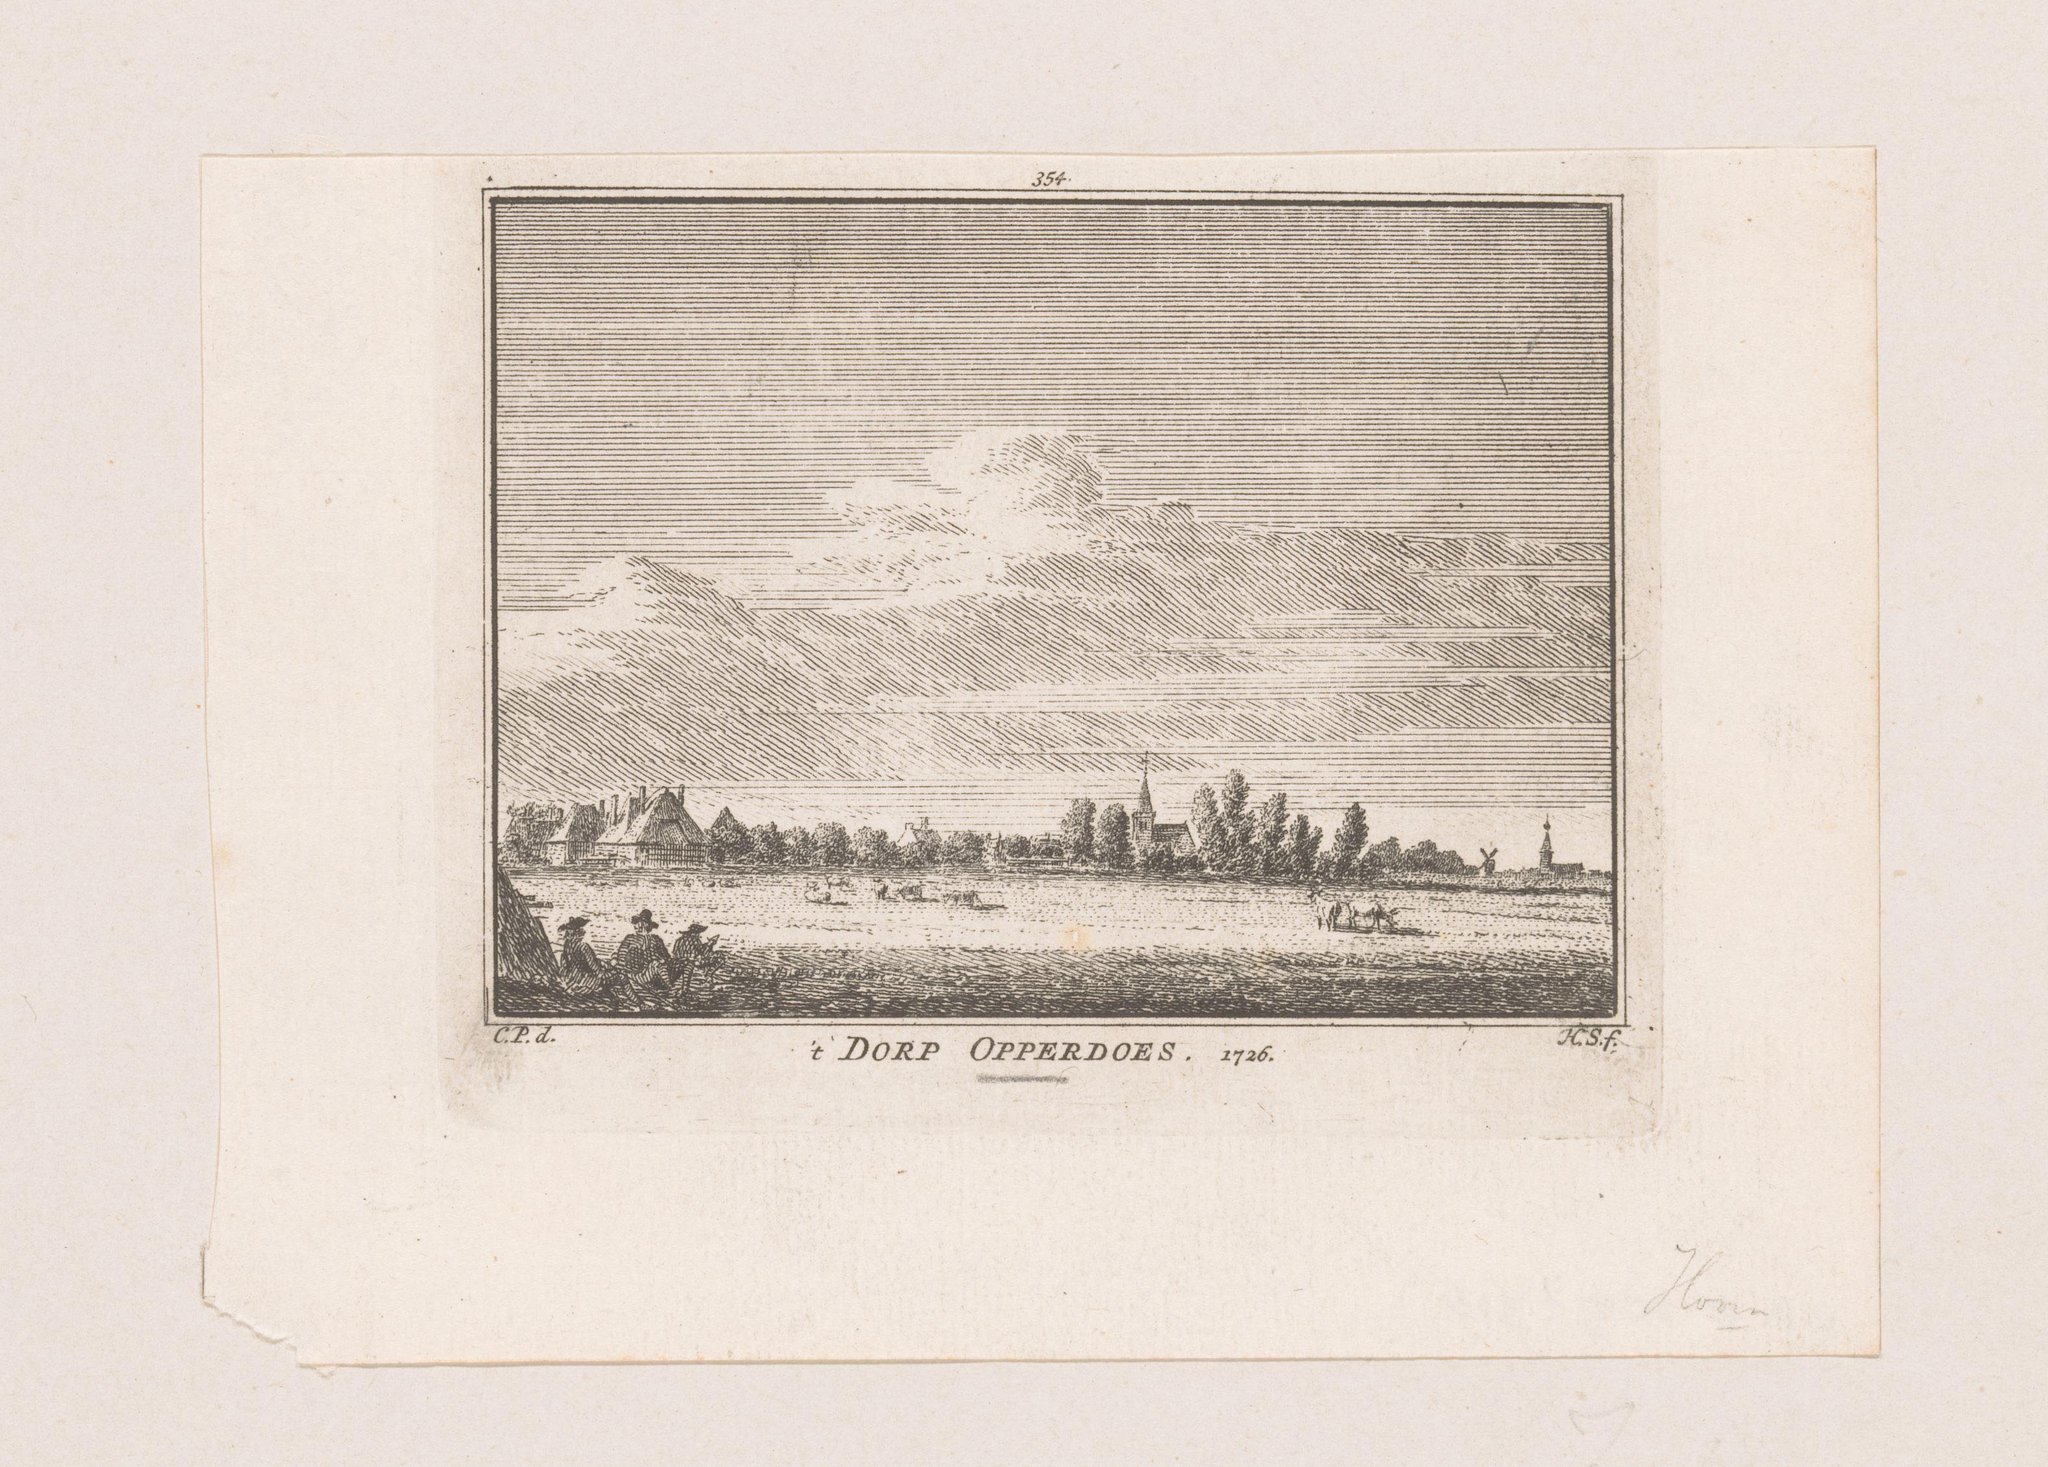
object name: print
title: 't Dorp Opperdoes, 1726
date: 1745-1774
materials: paper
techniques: etching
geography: amsterdam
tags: city-view, and landscape with man-made constructions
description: Prent verschenen in: Het verheerlykt Nederland of kabinet van hedendaagsche gezigten. Amsterdam: Isaac Tirion, 1745-1774.